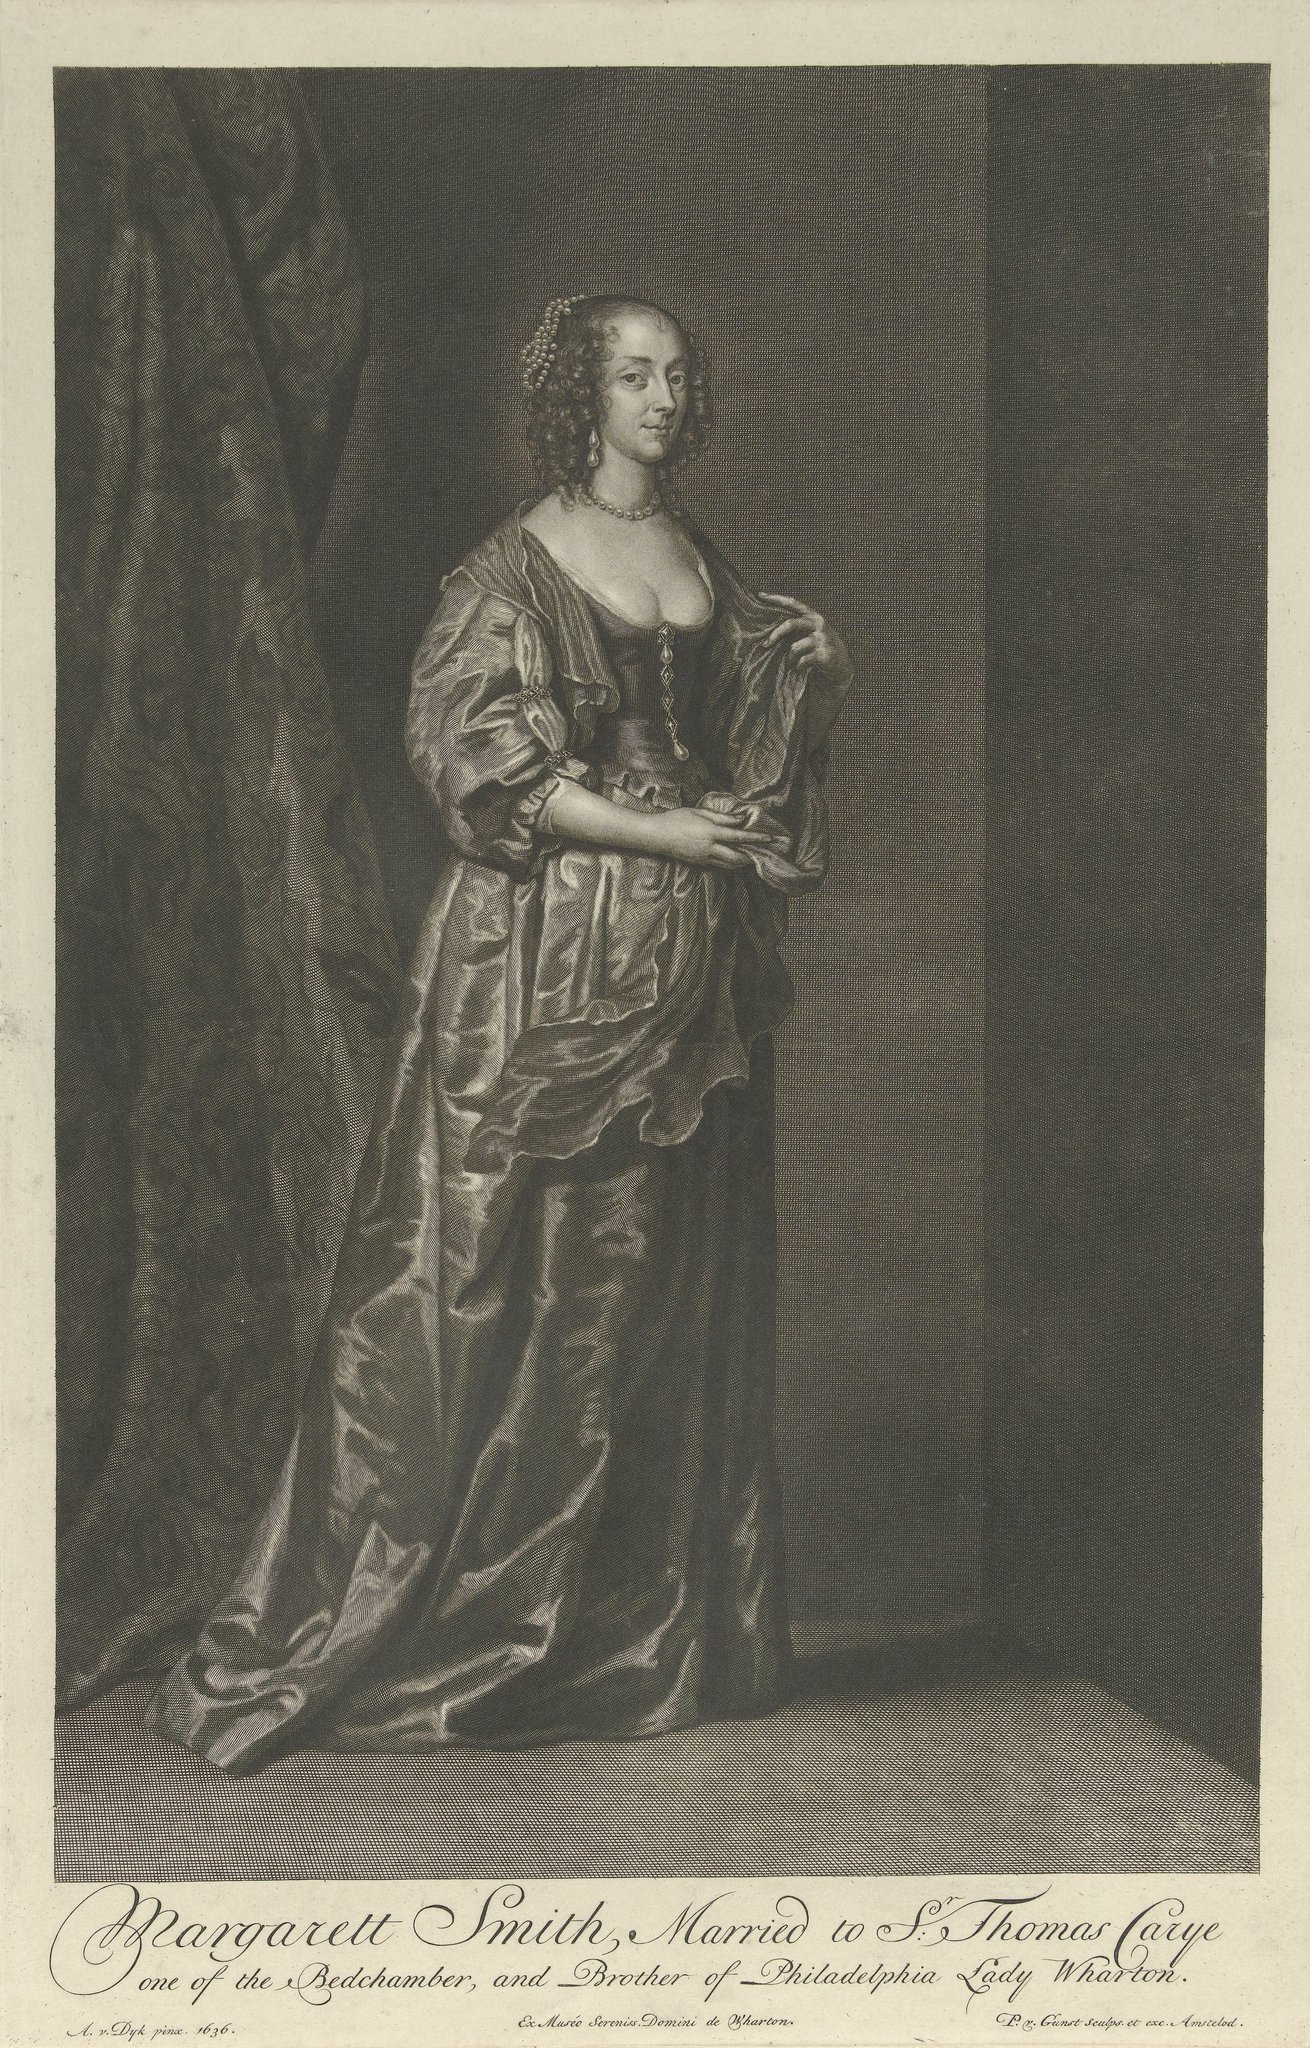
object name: book illustration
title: Portret van Margaret Smith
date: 1716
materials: paper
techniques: engraving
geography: amsterdam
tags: middlesex, margaret smith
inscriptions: collector's mark: Lugt 240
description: Boekillustratie voor Gunst, Pieter van. Decem Magna Arte Et Summa Dexteritate Pictas Effigies. Amsterdam, voor Pieter van Gunst, 1716.